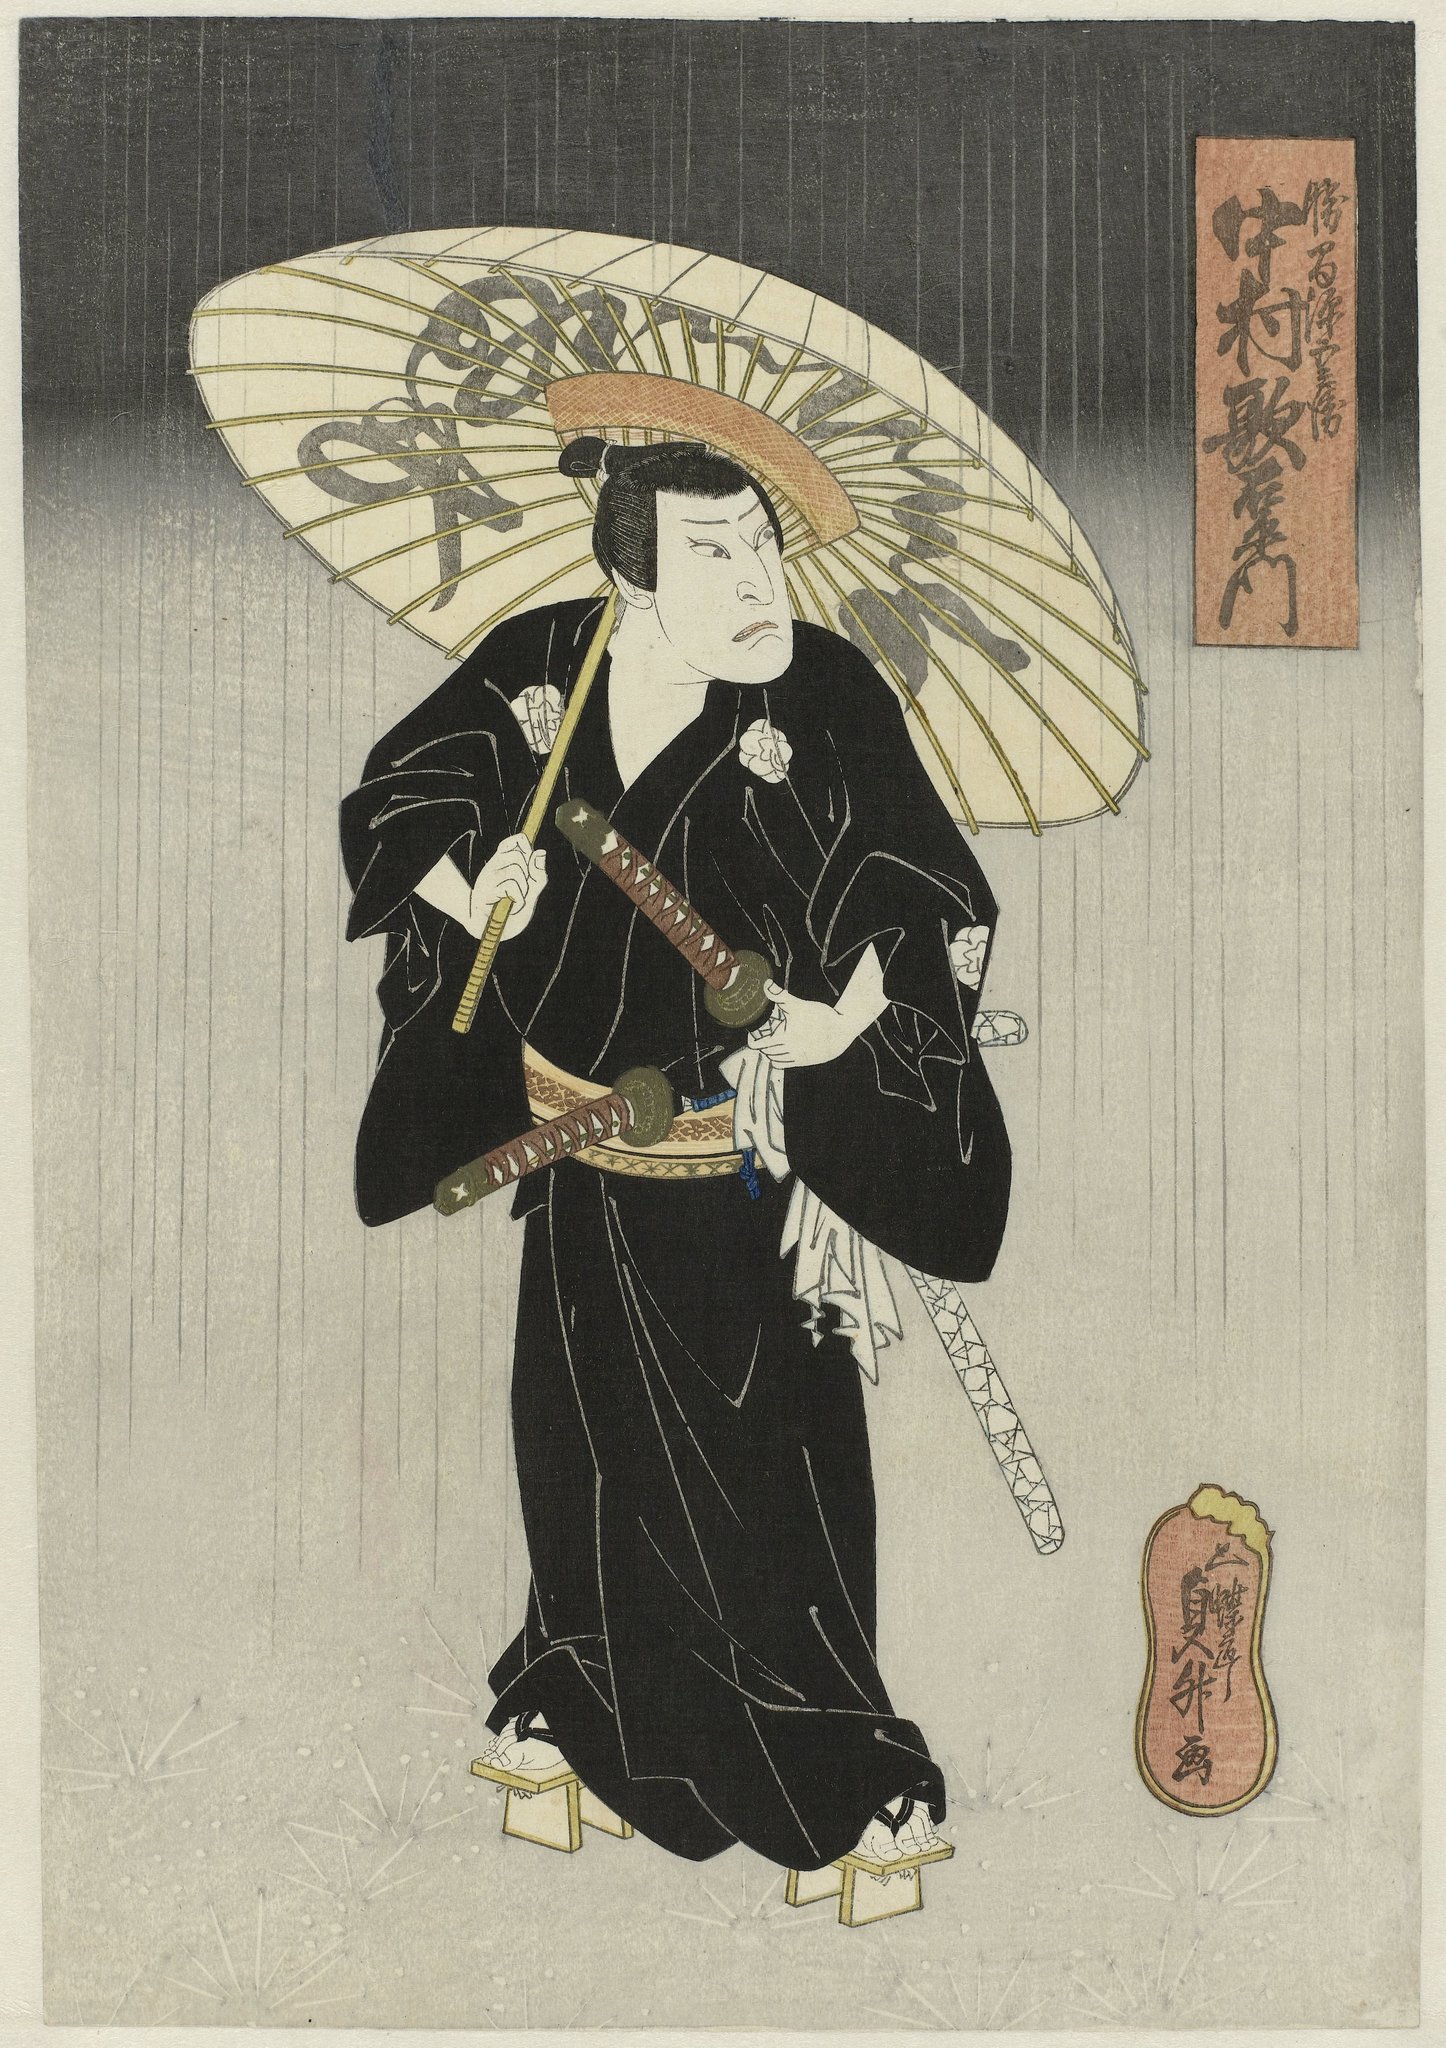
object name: print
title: Nakamura Utaemon IV als Katsuma Gengobei in het toneelstuk ‘Godairiki koi no fûjime’, Naka Theater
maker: utagawa sadamasu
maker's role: print maker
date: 1808-1837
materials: paper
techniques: woodcut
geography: osaka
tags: japan, umbrella, actor (on the stage)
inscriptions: signature: ‘Gochôtei Sadamasu ga’